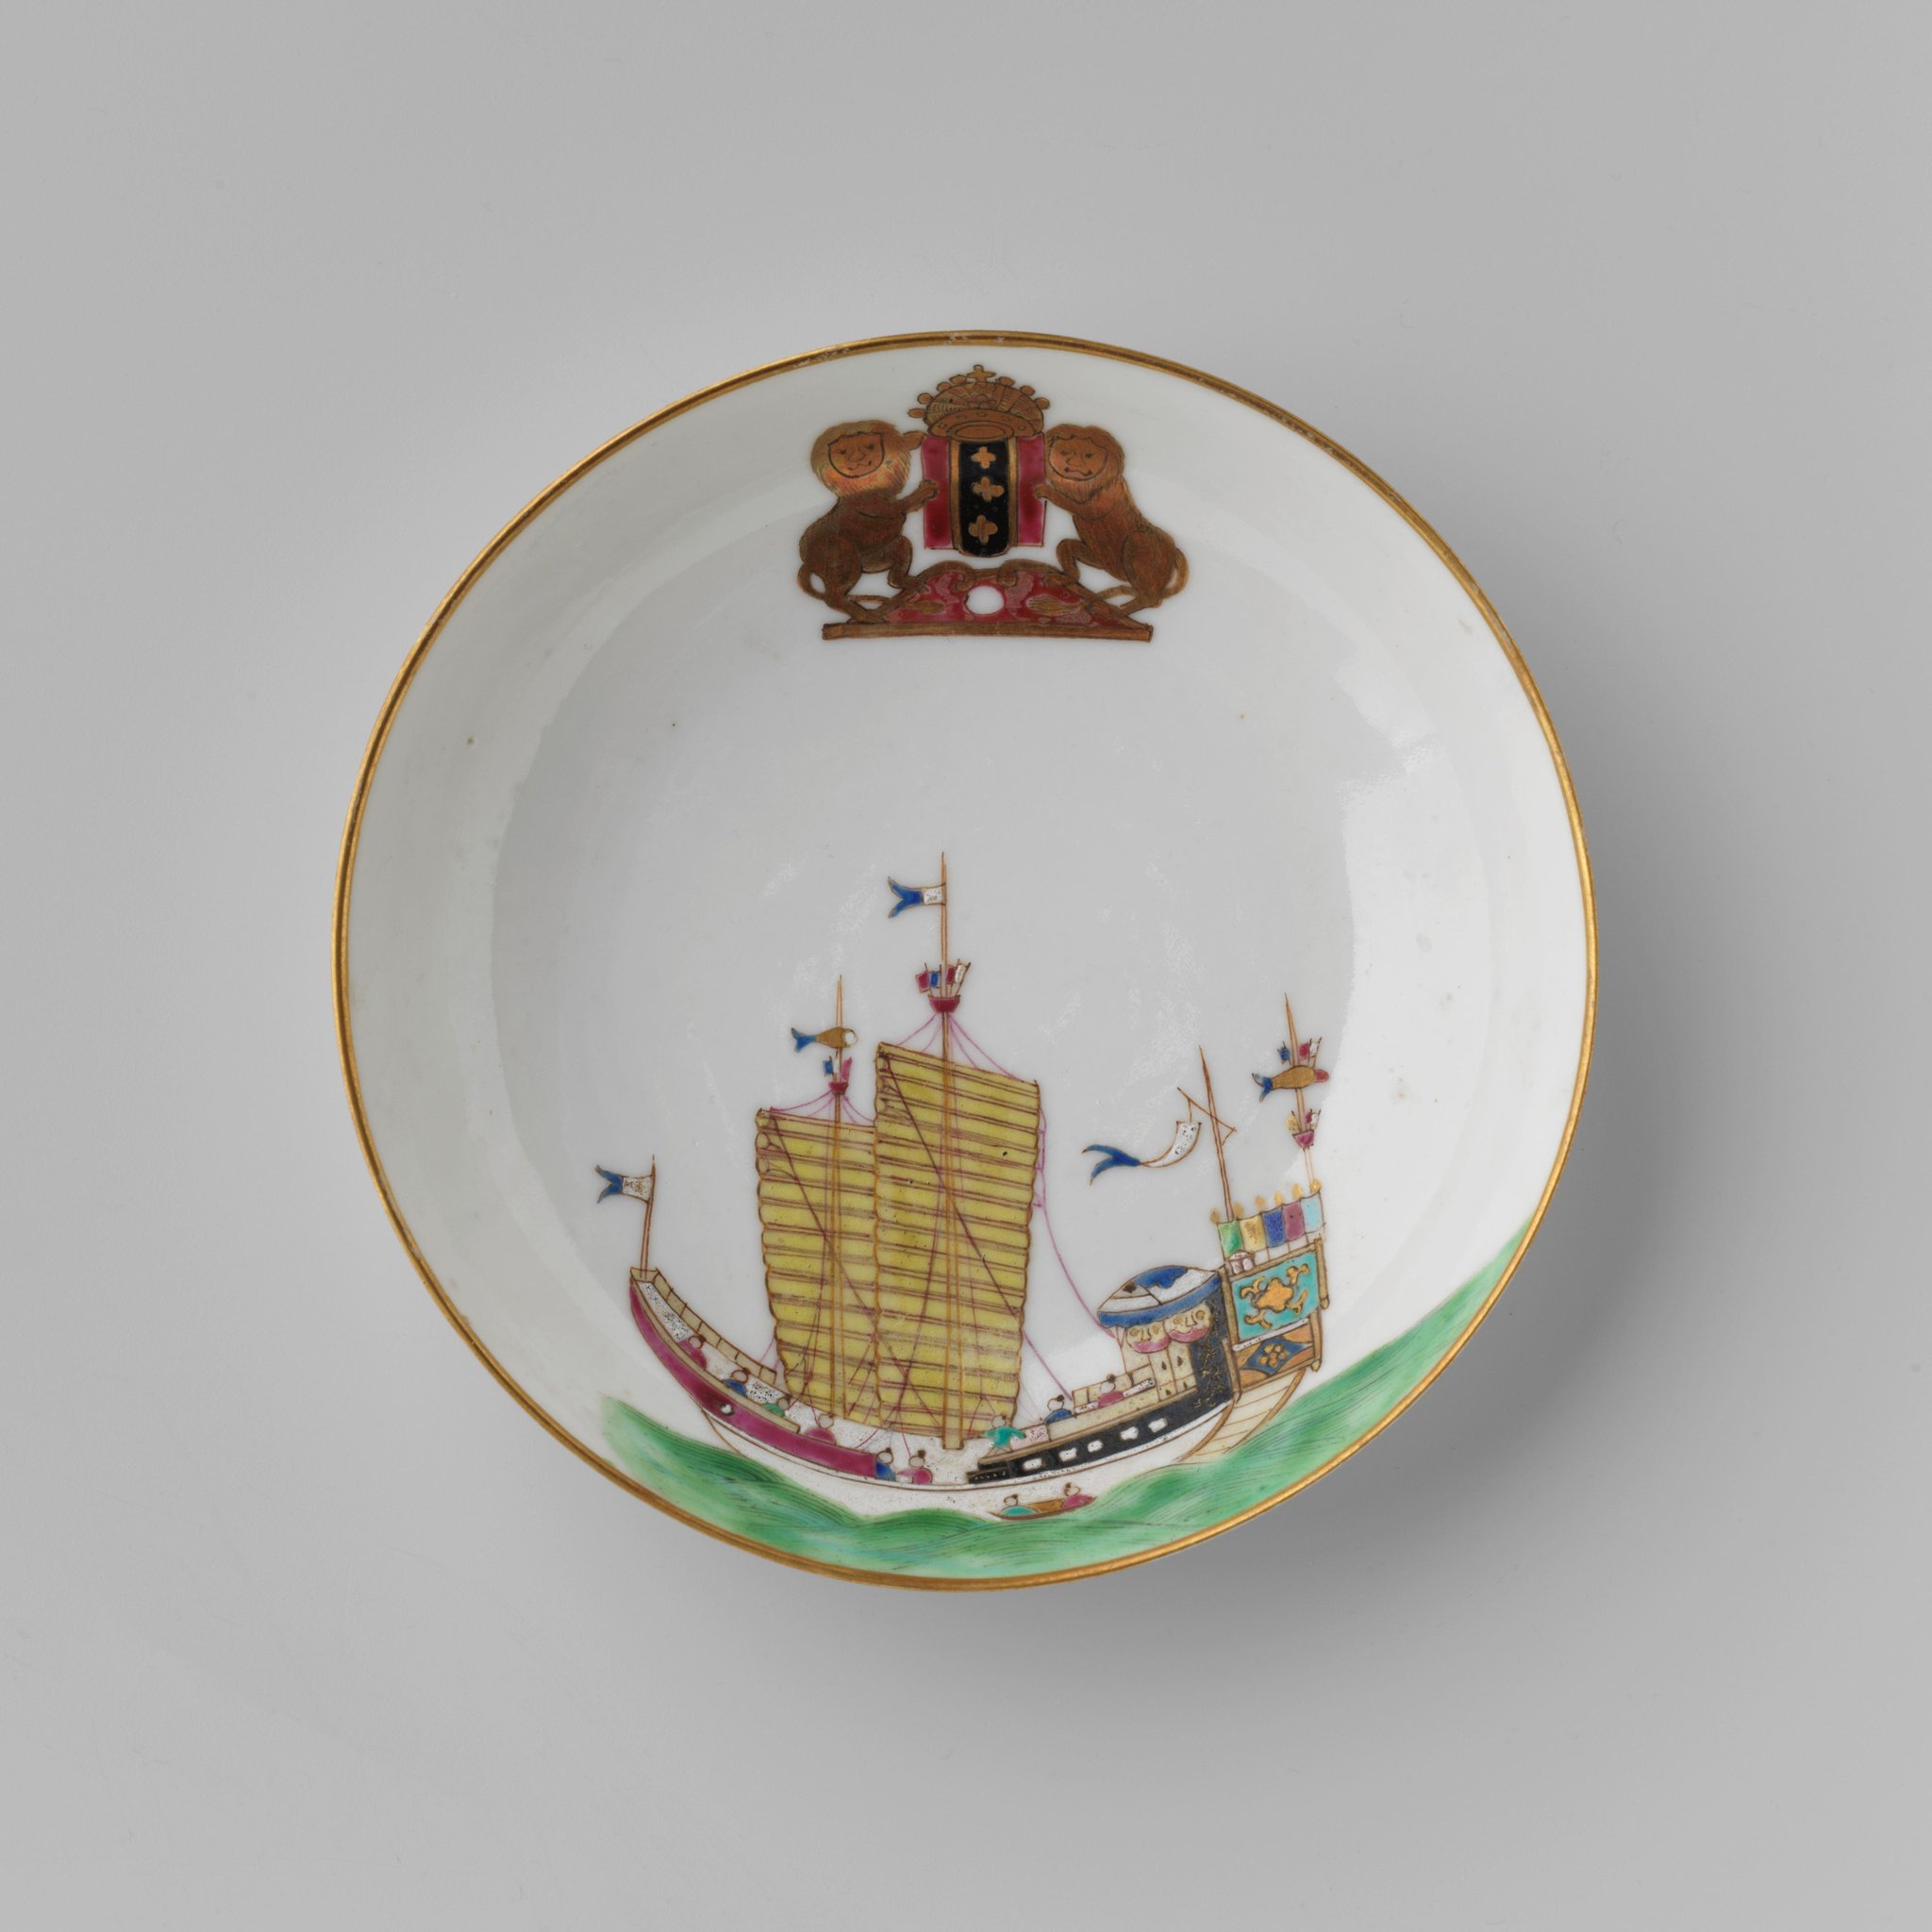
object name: platter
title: Saucer with a Chinese junk and the arms of Amsterdam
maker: Anonymous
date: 1800-1899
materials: glaze, gold, paint, porcelain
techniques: firing, gilding, turning, vitrification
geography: china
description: Kop en schotel van porselein. de kop is versierd met aan de ene zijde het wapen van Amsterdam, gehouden door twee leeuwen, en aan de andere zijde een Chineesche jonk. Op de schotel staat dezelfde versiering. 'Chine de Commande'.